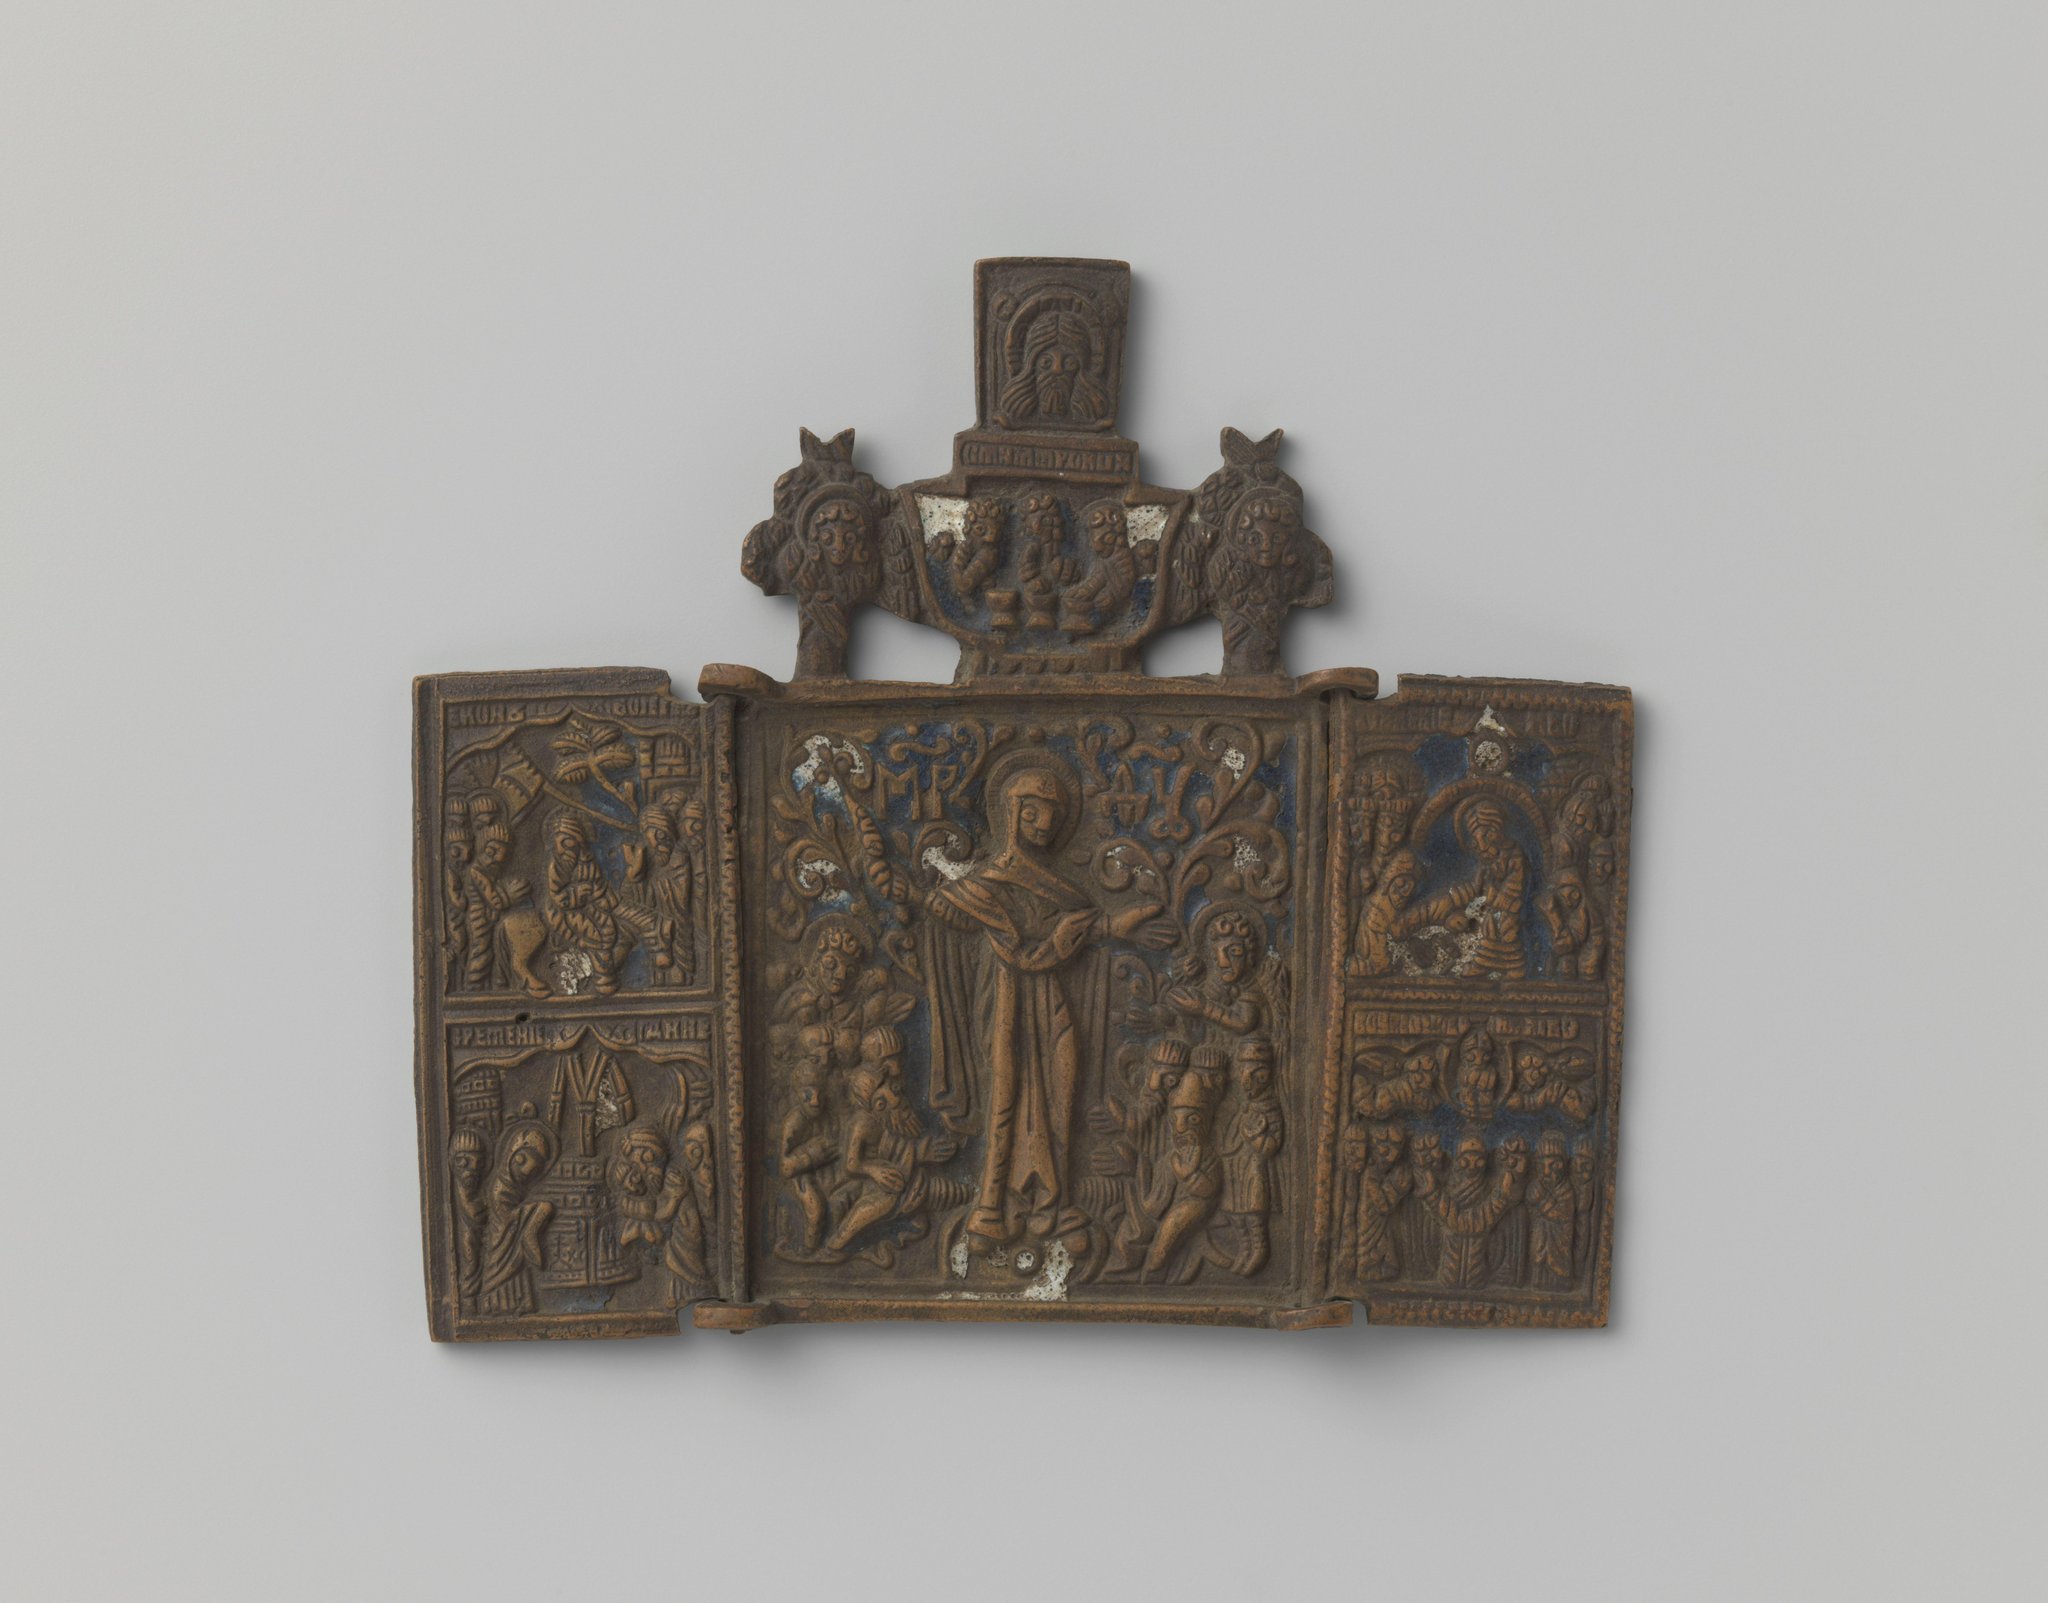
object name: triptych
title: Triptiek met de Moeder Gods omgeven door heiligen en scènes uit het leven van Christus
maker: Anonymous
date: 1800-1850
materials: copper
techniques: casting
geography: russia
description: Het in drie delen gegoten voorwerp, dat als reisicoon werd gebruikt, bestaat uit een middenluik met bovenstuk en twee zijluiken. Op het middenluik de Moeder Gods omgeven door heiligen en andere figuren. Op de zijluiken: de intocht in Jeruzalem, de Opdracht in de tempel, Christus in het voorgeborchte, en de hemelvaart van Christus. Het bovenstuk geeft het hoofd van Christus weer (het Mandilion), drie engelen (uit het Gastmaal van Abraham) en twee serafijnen.